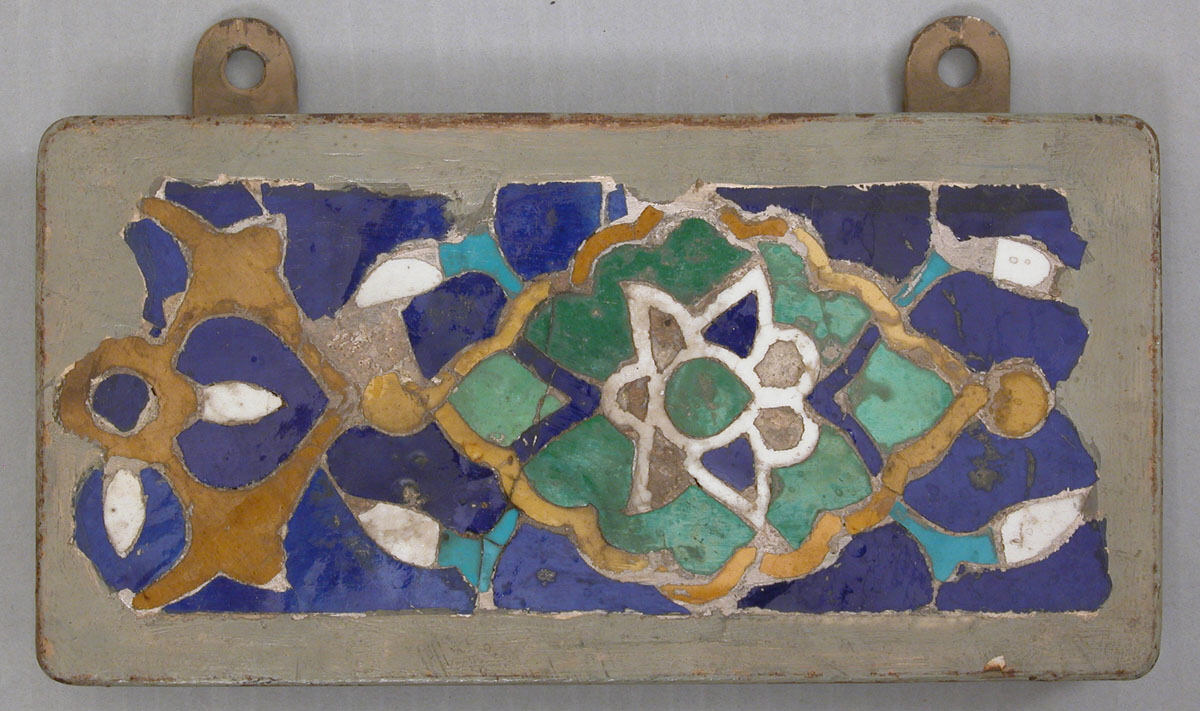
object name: tile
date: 1567-1600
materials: stonepaste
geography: uzbekistan